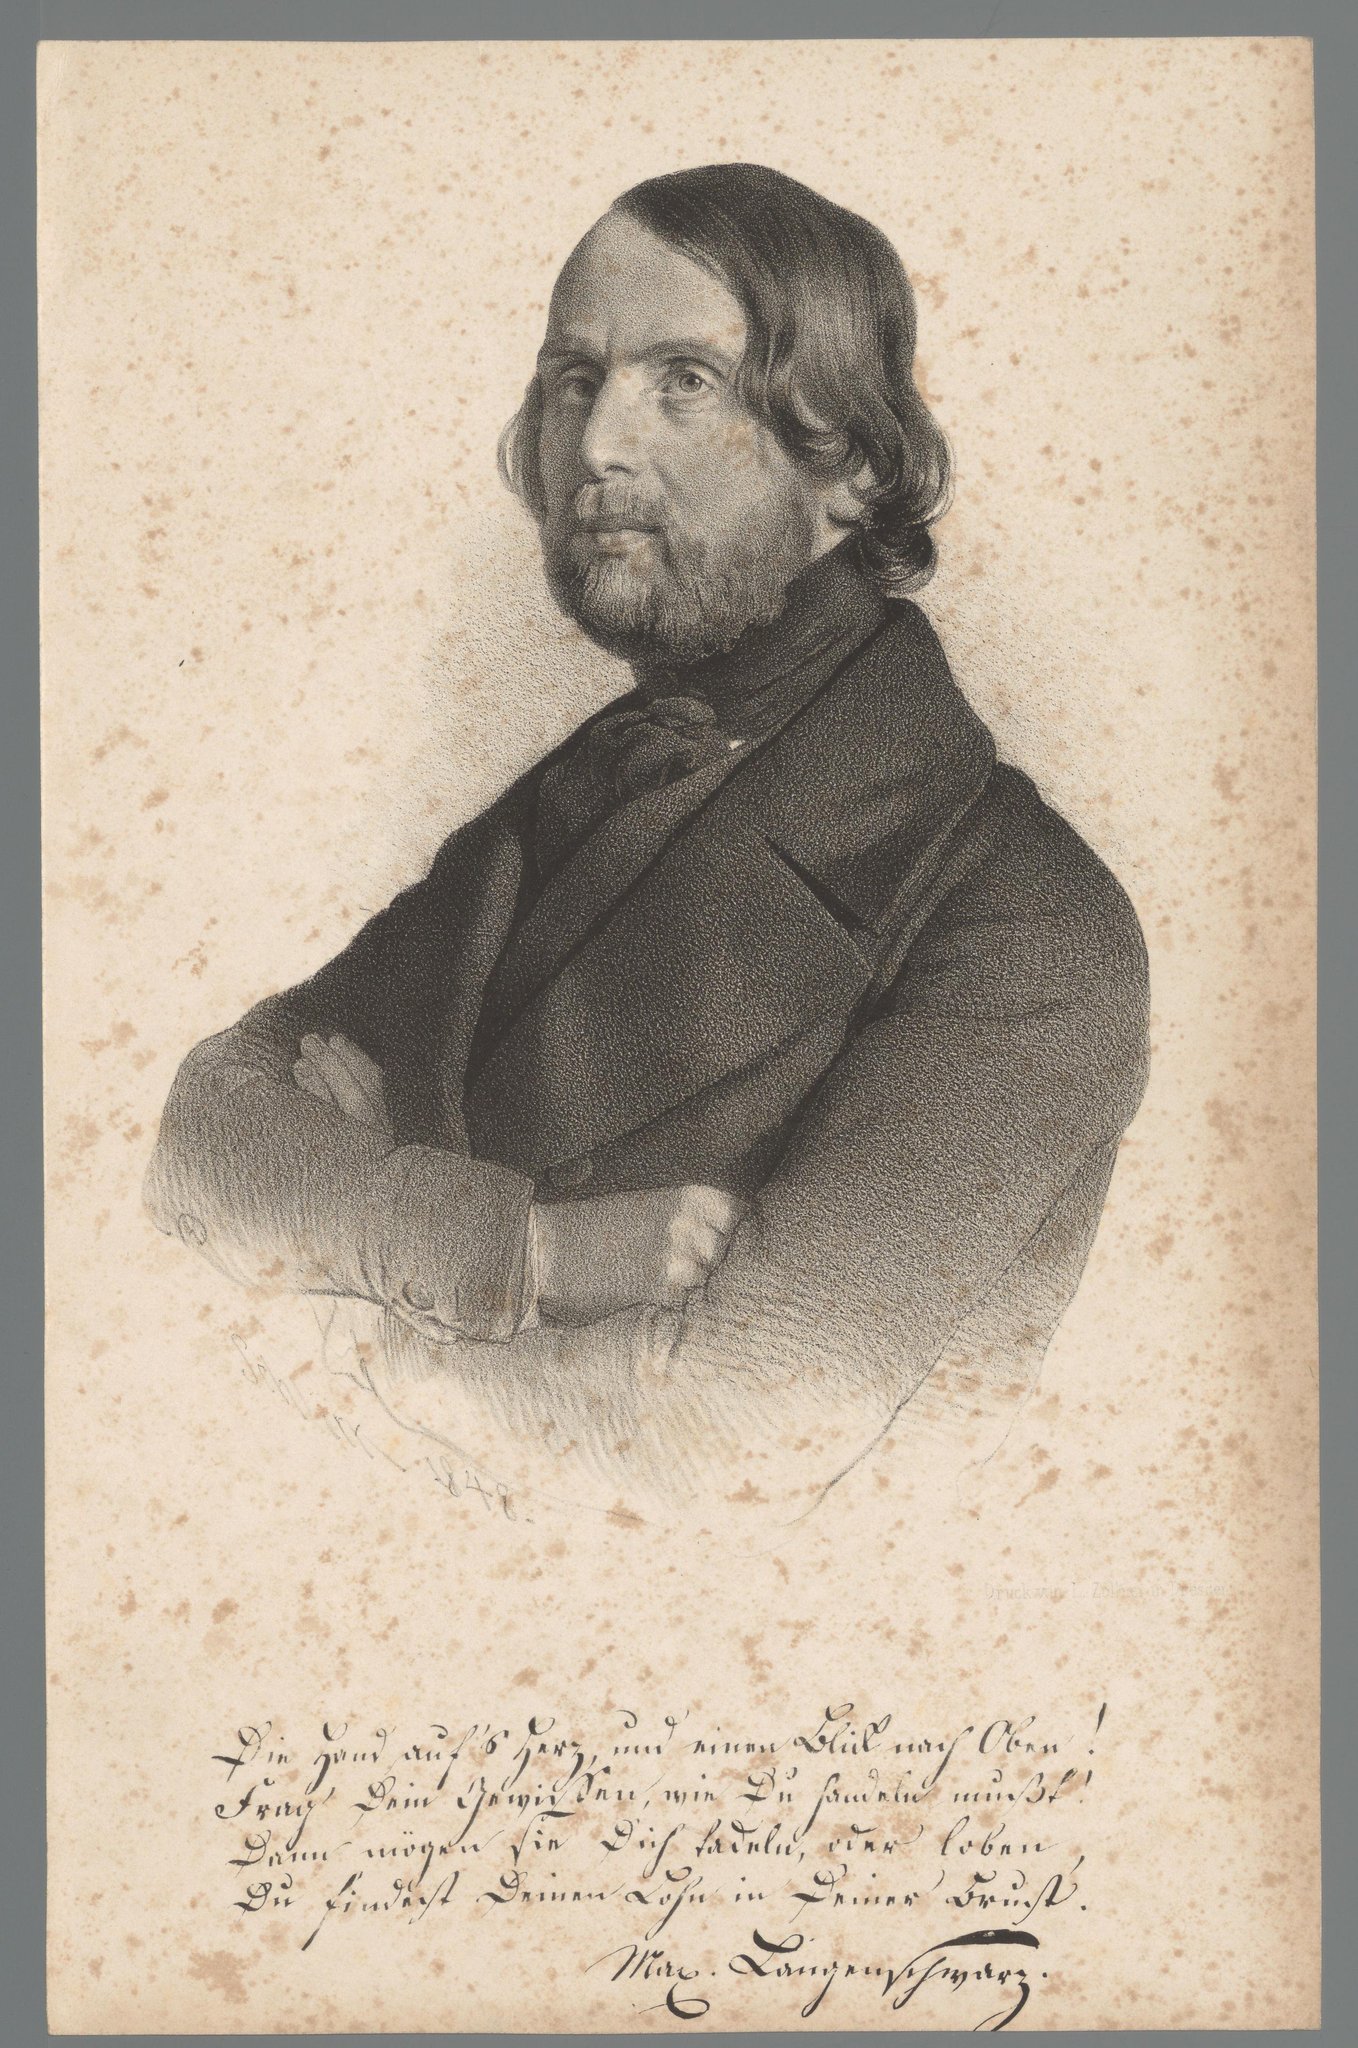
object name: print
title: Portret van Langenschwarz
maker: gustav schlick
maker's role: print maker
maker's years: 1804-1869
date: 1848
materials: paper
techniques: lithograph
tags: historical persons not known by name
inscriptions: collector's mark: Lugt 2228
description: Portret van een verder onbekende man, met handtekening in facsimile waarin mogelijk de naam Mr. Langenschwarz te lezen is.